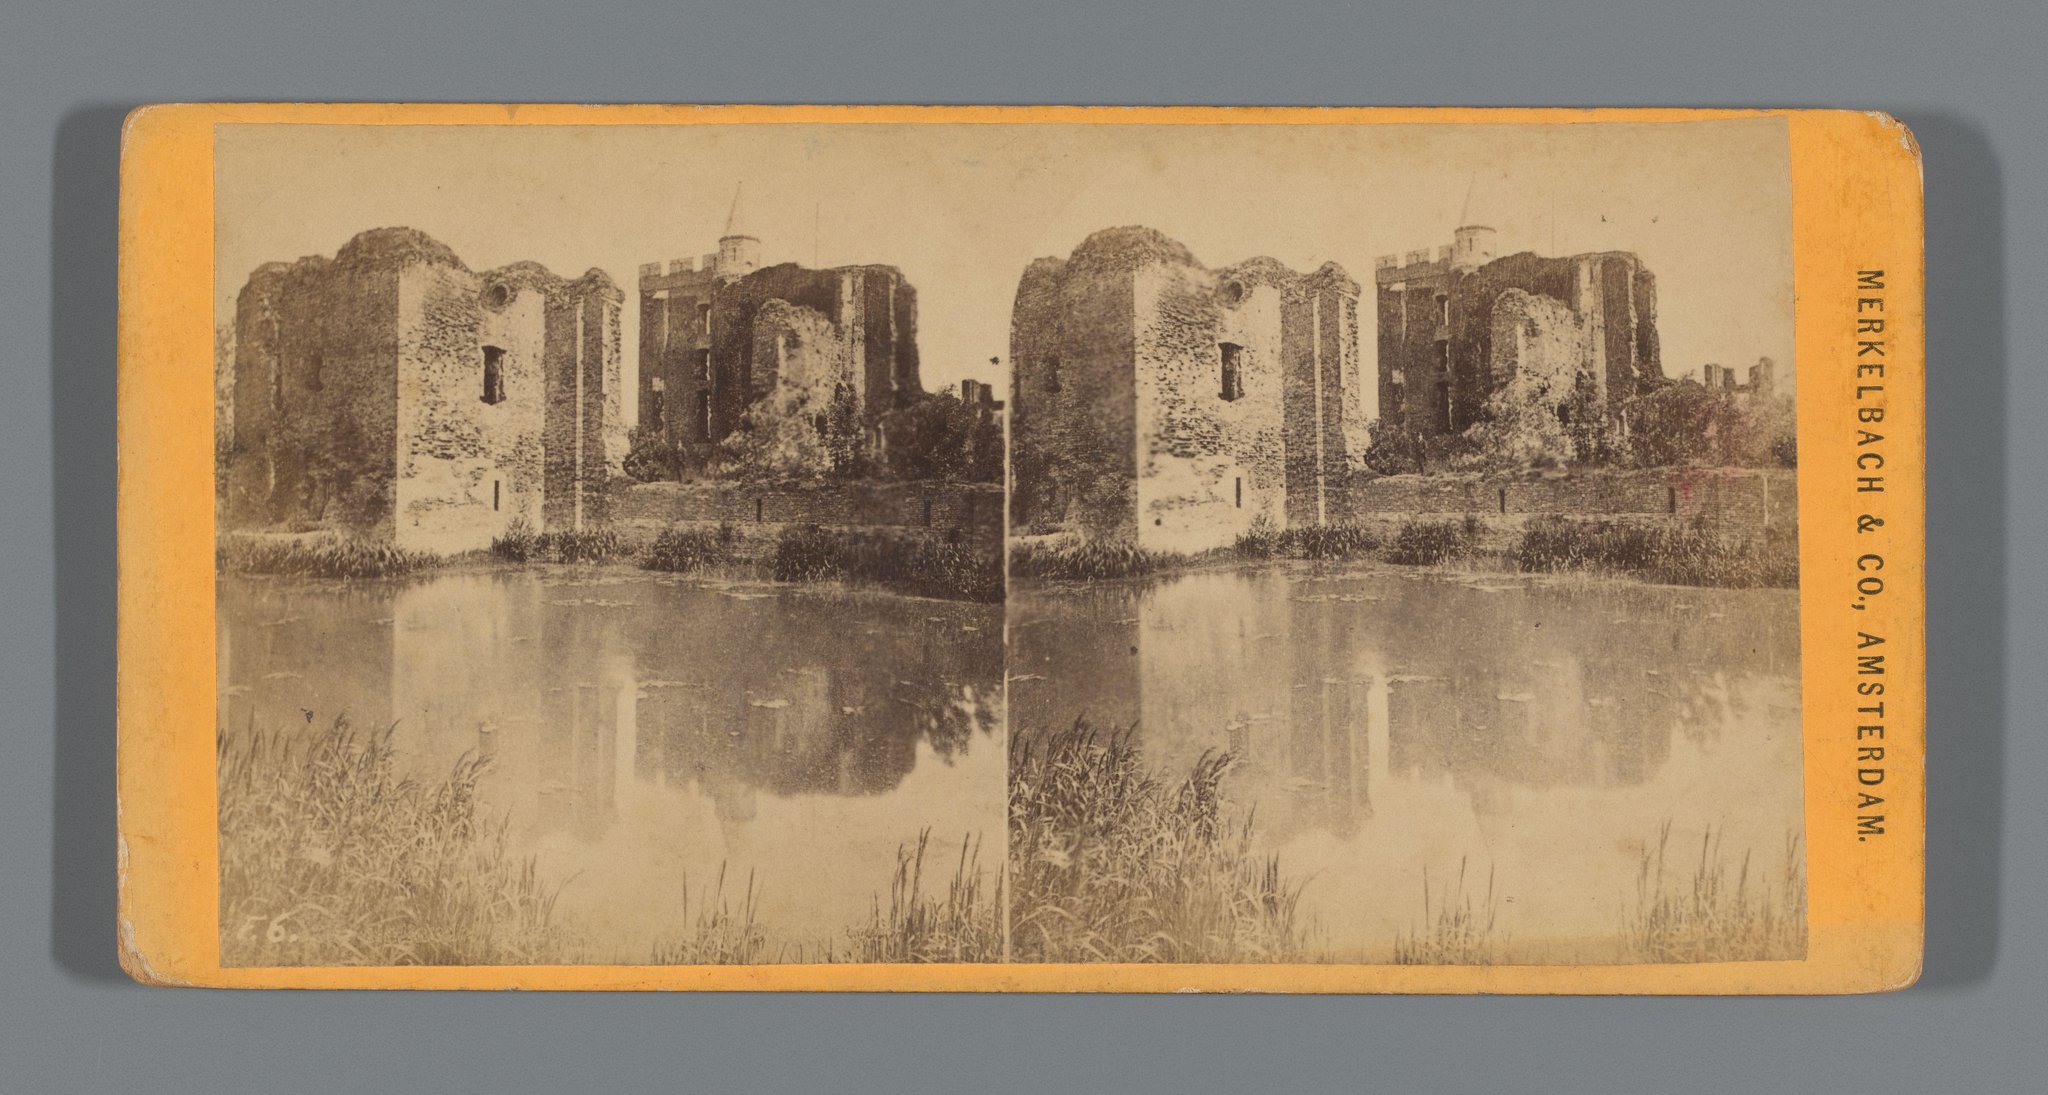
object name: stereograph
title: Aardrijkskundige Beeldengalerij, verzameld door M.J. Broekhuijsen, Hoofd eener school te Amsterdam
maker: martien johan broekhuijsen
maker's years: 1871-1956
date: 1905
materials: photographic support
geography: amsterdam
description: Onderdeel van een groep van 52 stereofoto's gebruikt in het lager onderwijs als aanvulling op schoolplaten. De gehele reeks bestond uit 274 nummers in 10 categorieën (A t/m K).